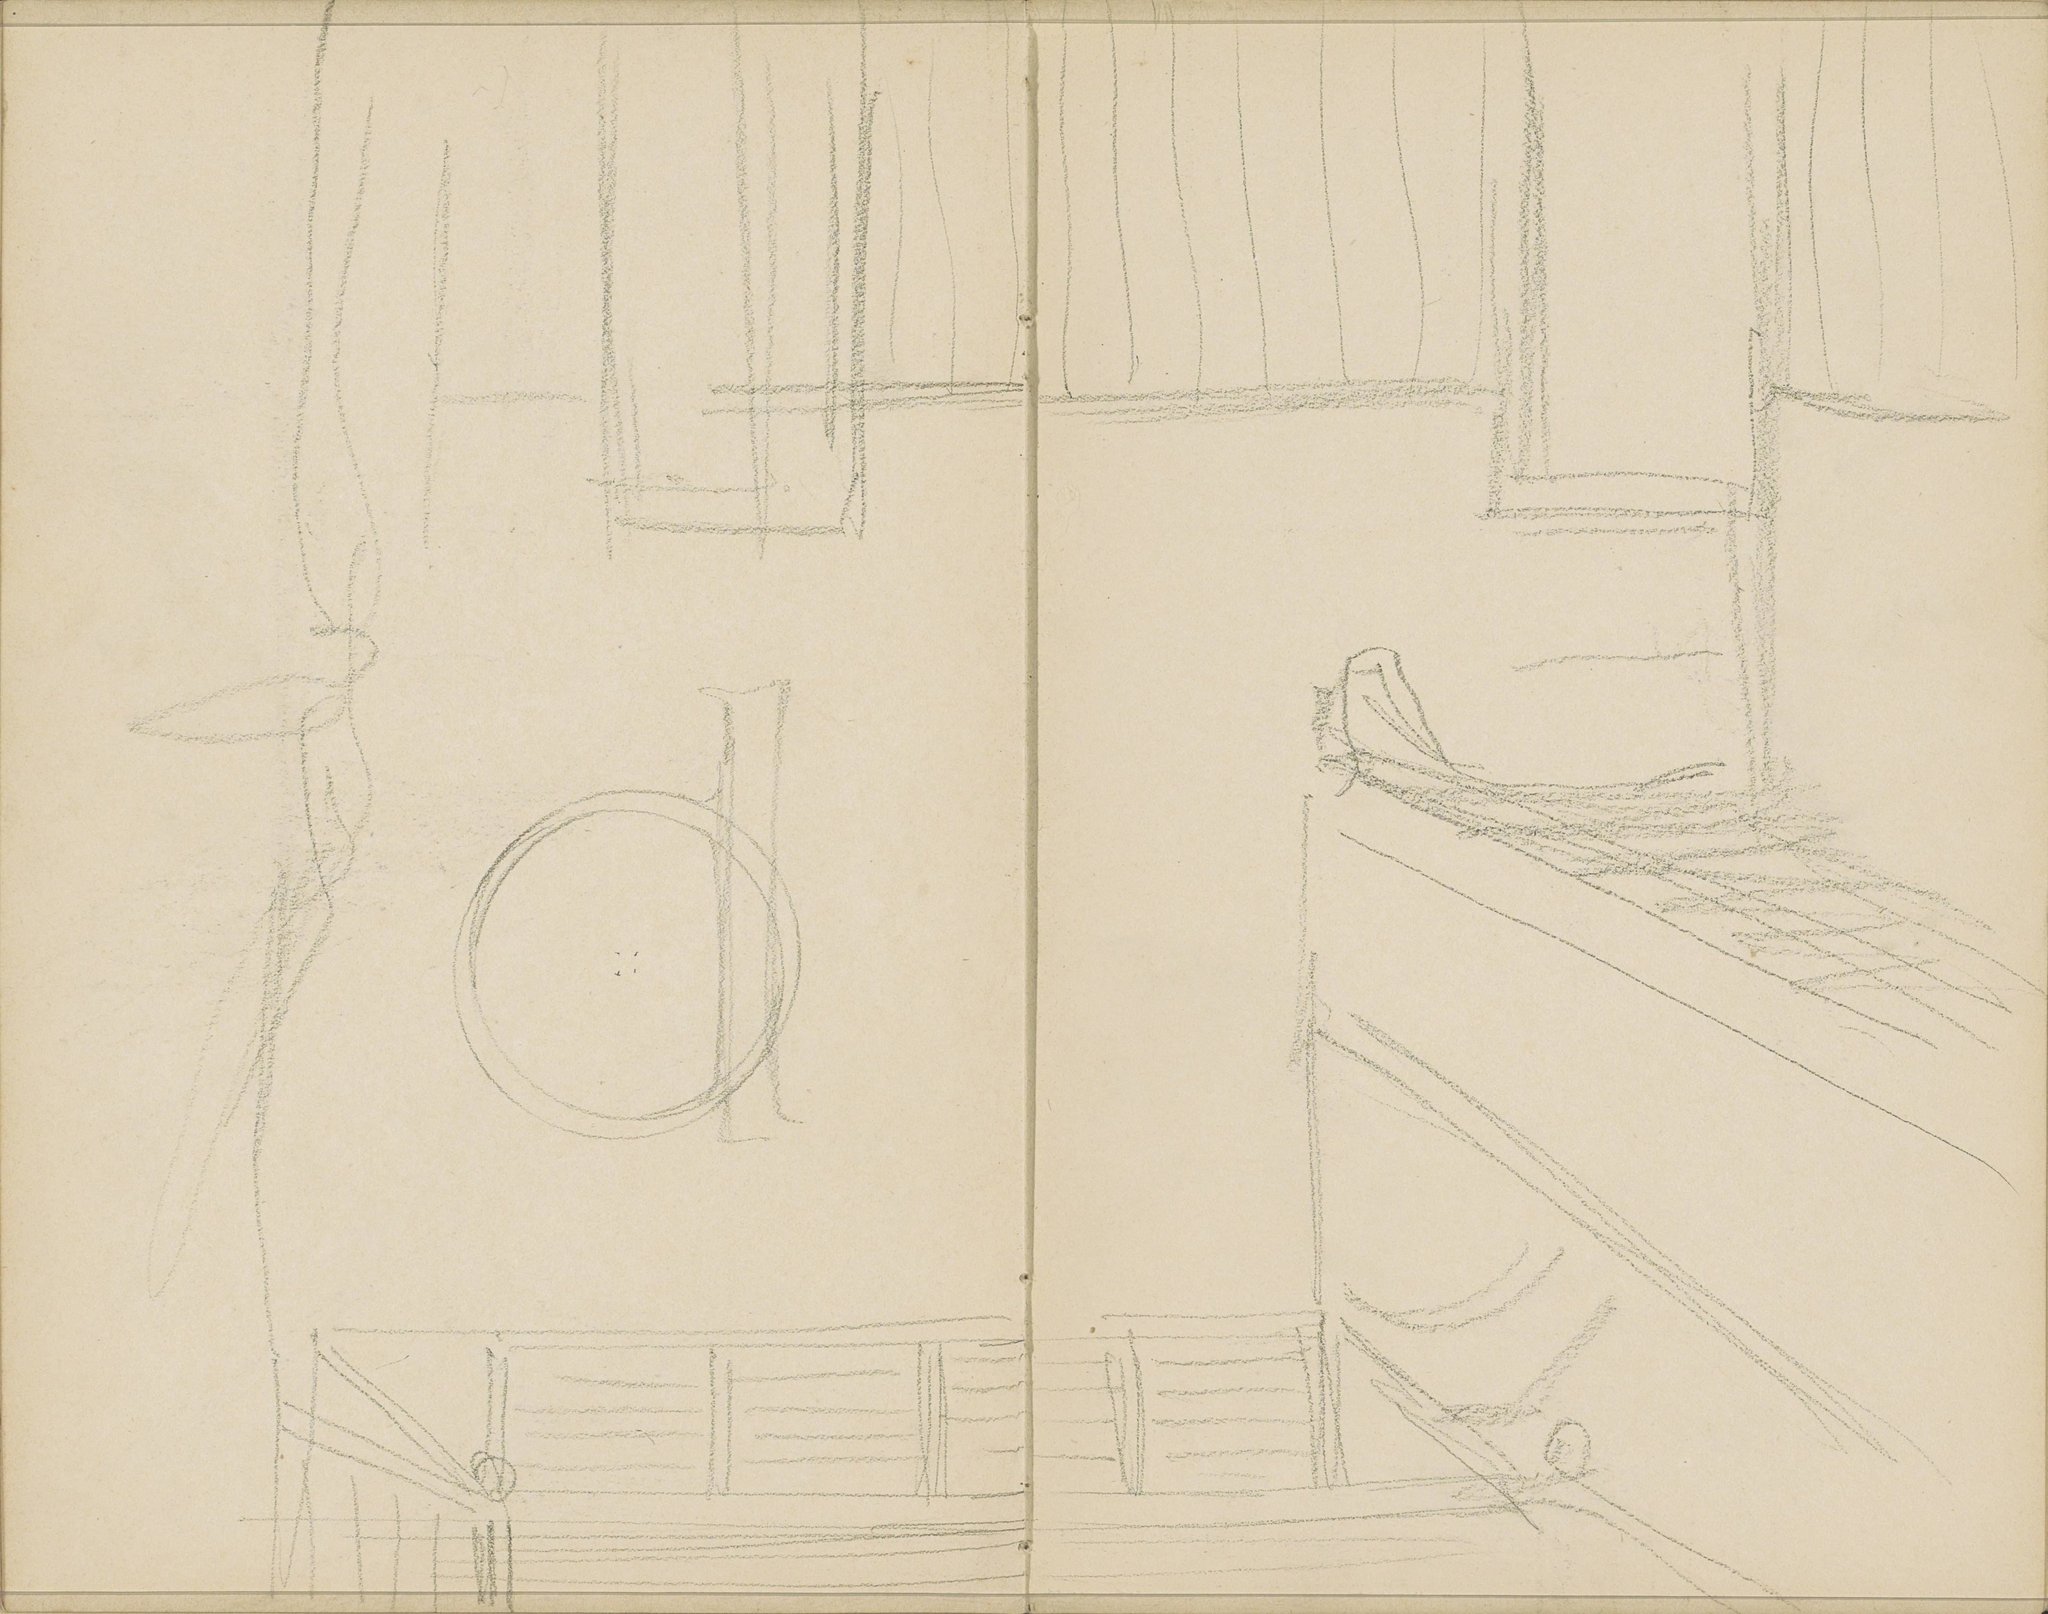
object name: sketchbook leaf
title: Interieur met lambrisering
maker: antoon derkinderen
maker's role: draughtsman, painter, print maker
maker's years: 1859-1925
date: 1889-1894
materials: paper, pencil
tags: wainscoting, interior of the house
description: Blad 13 verso en 14 recto uit een schetsboek met 33 bladen.